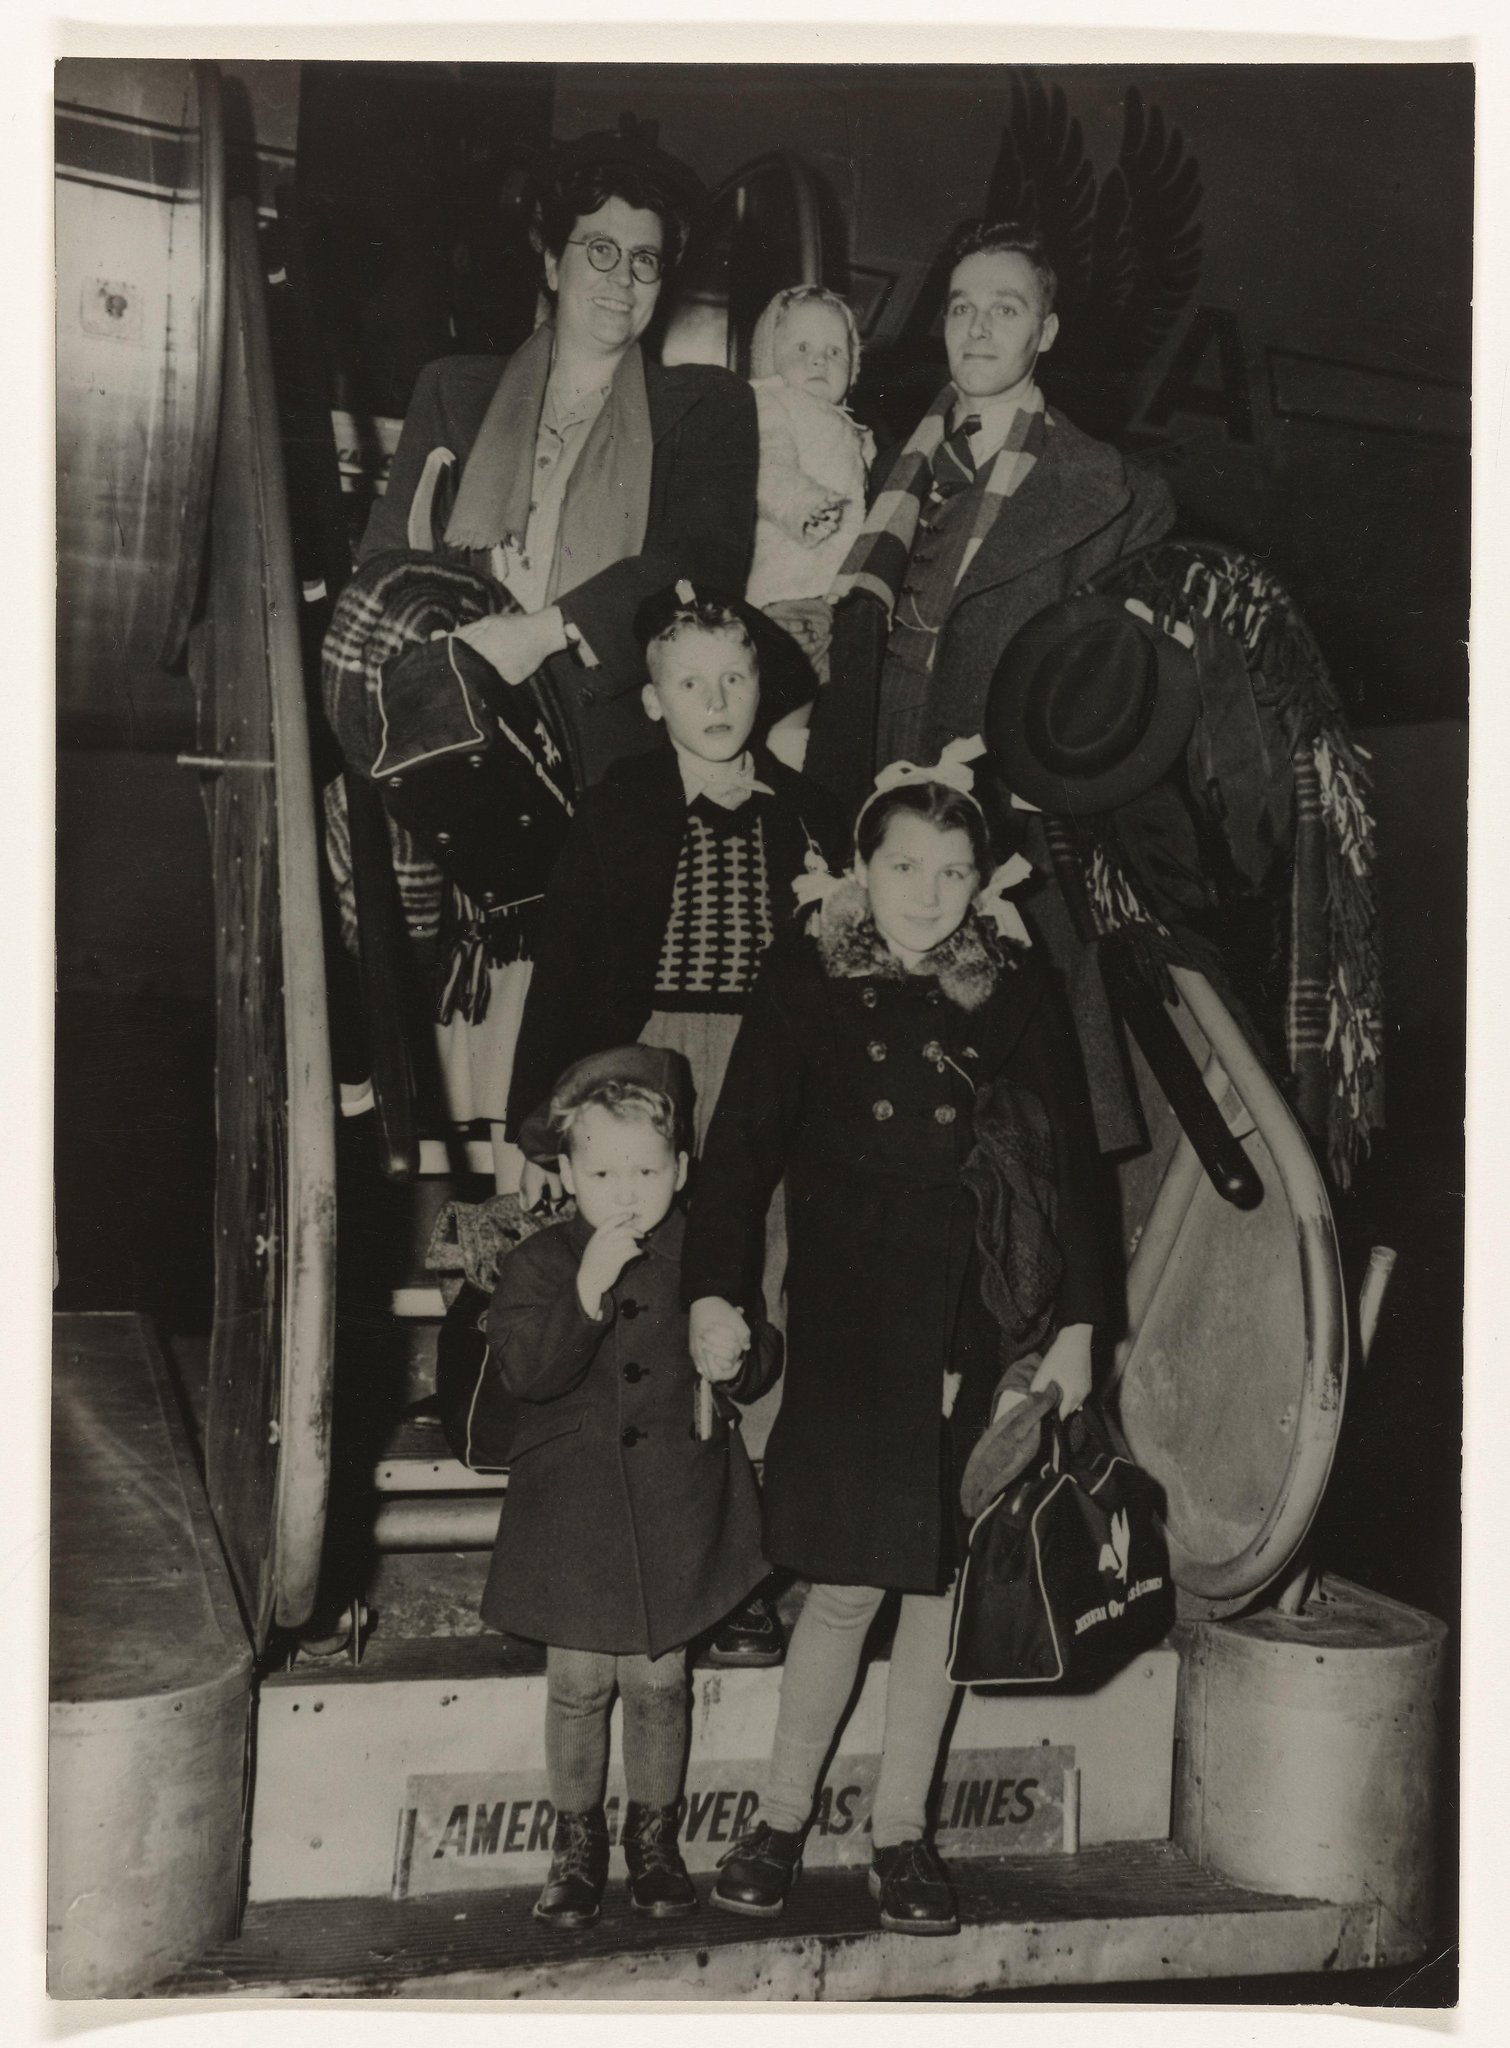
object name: photograph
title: Emigratie naar Amerika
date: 1949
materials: photographic support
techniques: photography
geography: new york city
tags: new york (city)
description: Het Nederlandse boeren gezin Dillingh arriveert vanuit Amsterdam op de luchthaven van New York met hun vier kinderen. Zij gaan zich op een boerderij vestigen in de staat New York